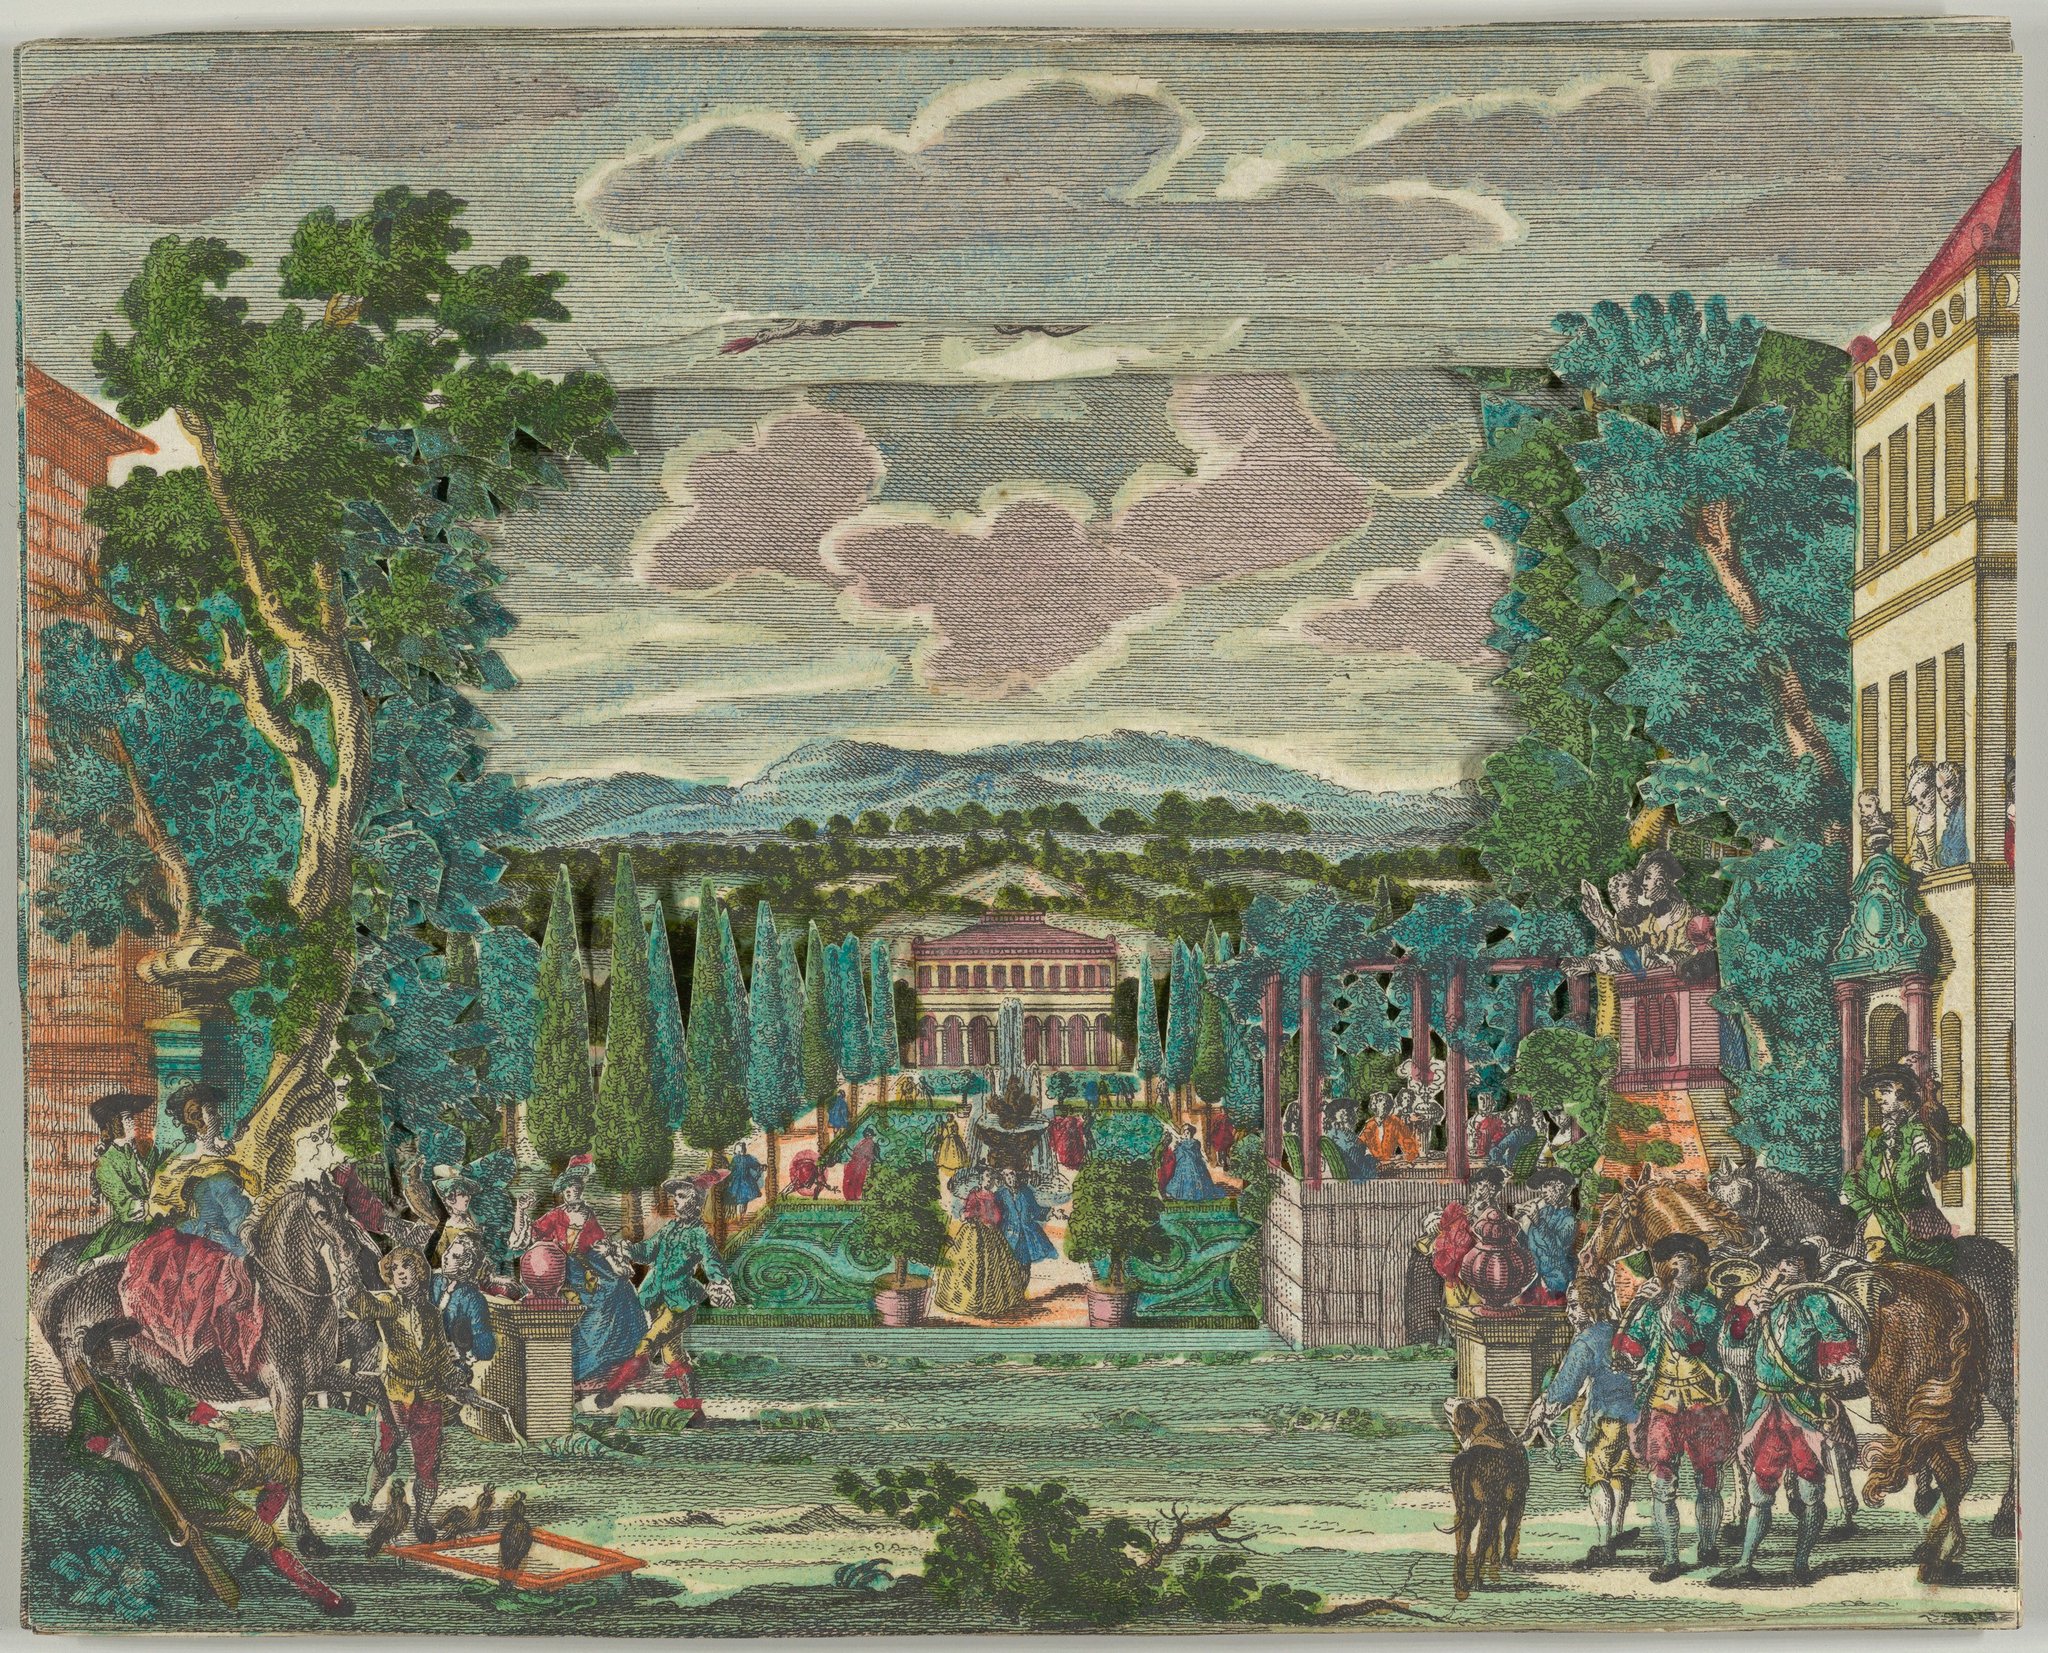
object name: print ornament architecture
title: Paper Theater or Diorama of an Italianate Villa and Garden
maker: martin engelbrecht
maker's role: publisher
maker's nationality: german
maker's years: 1684-1756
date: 1730-1756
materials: watercolor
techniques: etching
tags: theatre,gardens,men,women,horses